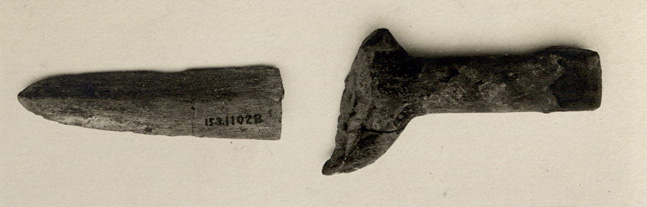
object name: model dagger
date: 1981-1640 BCE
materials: wood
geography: egypt